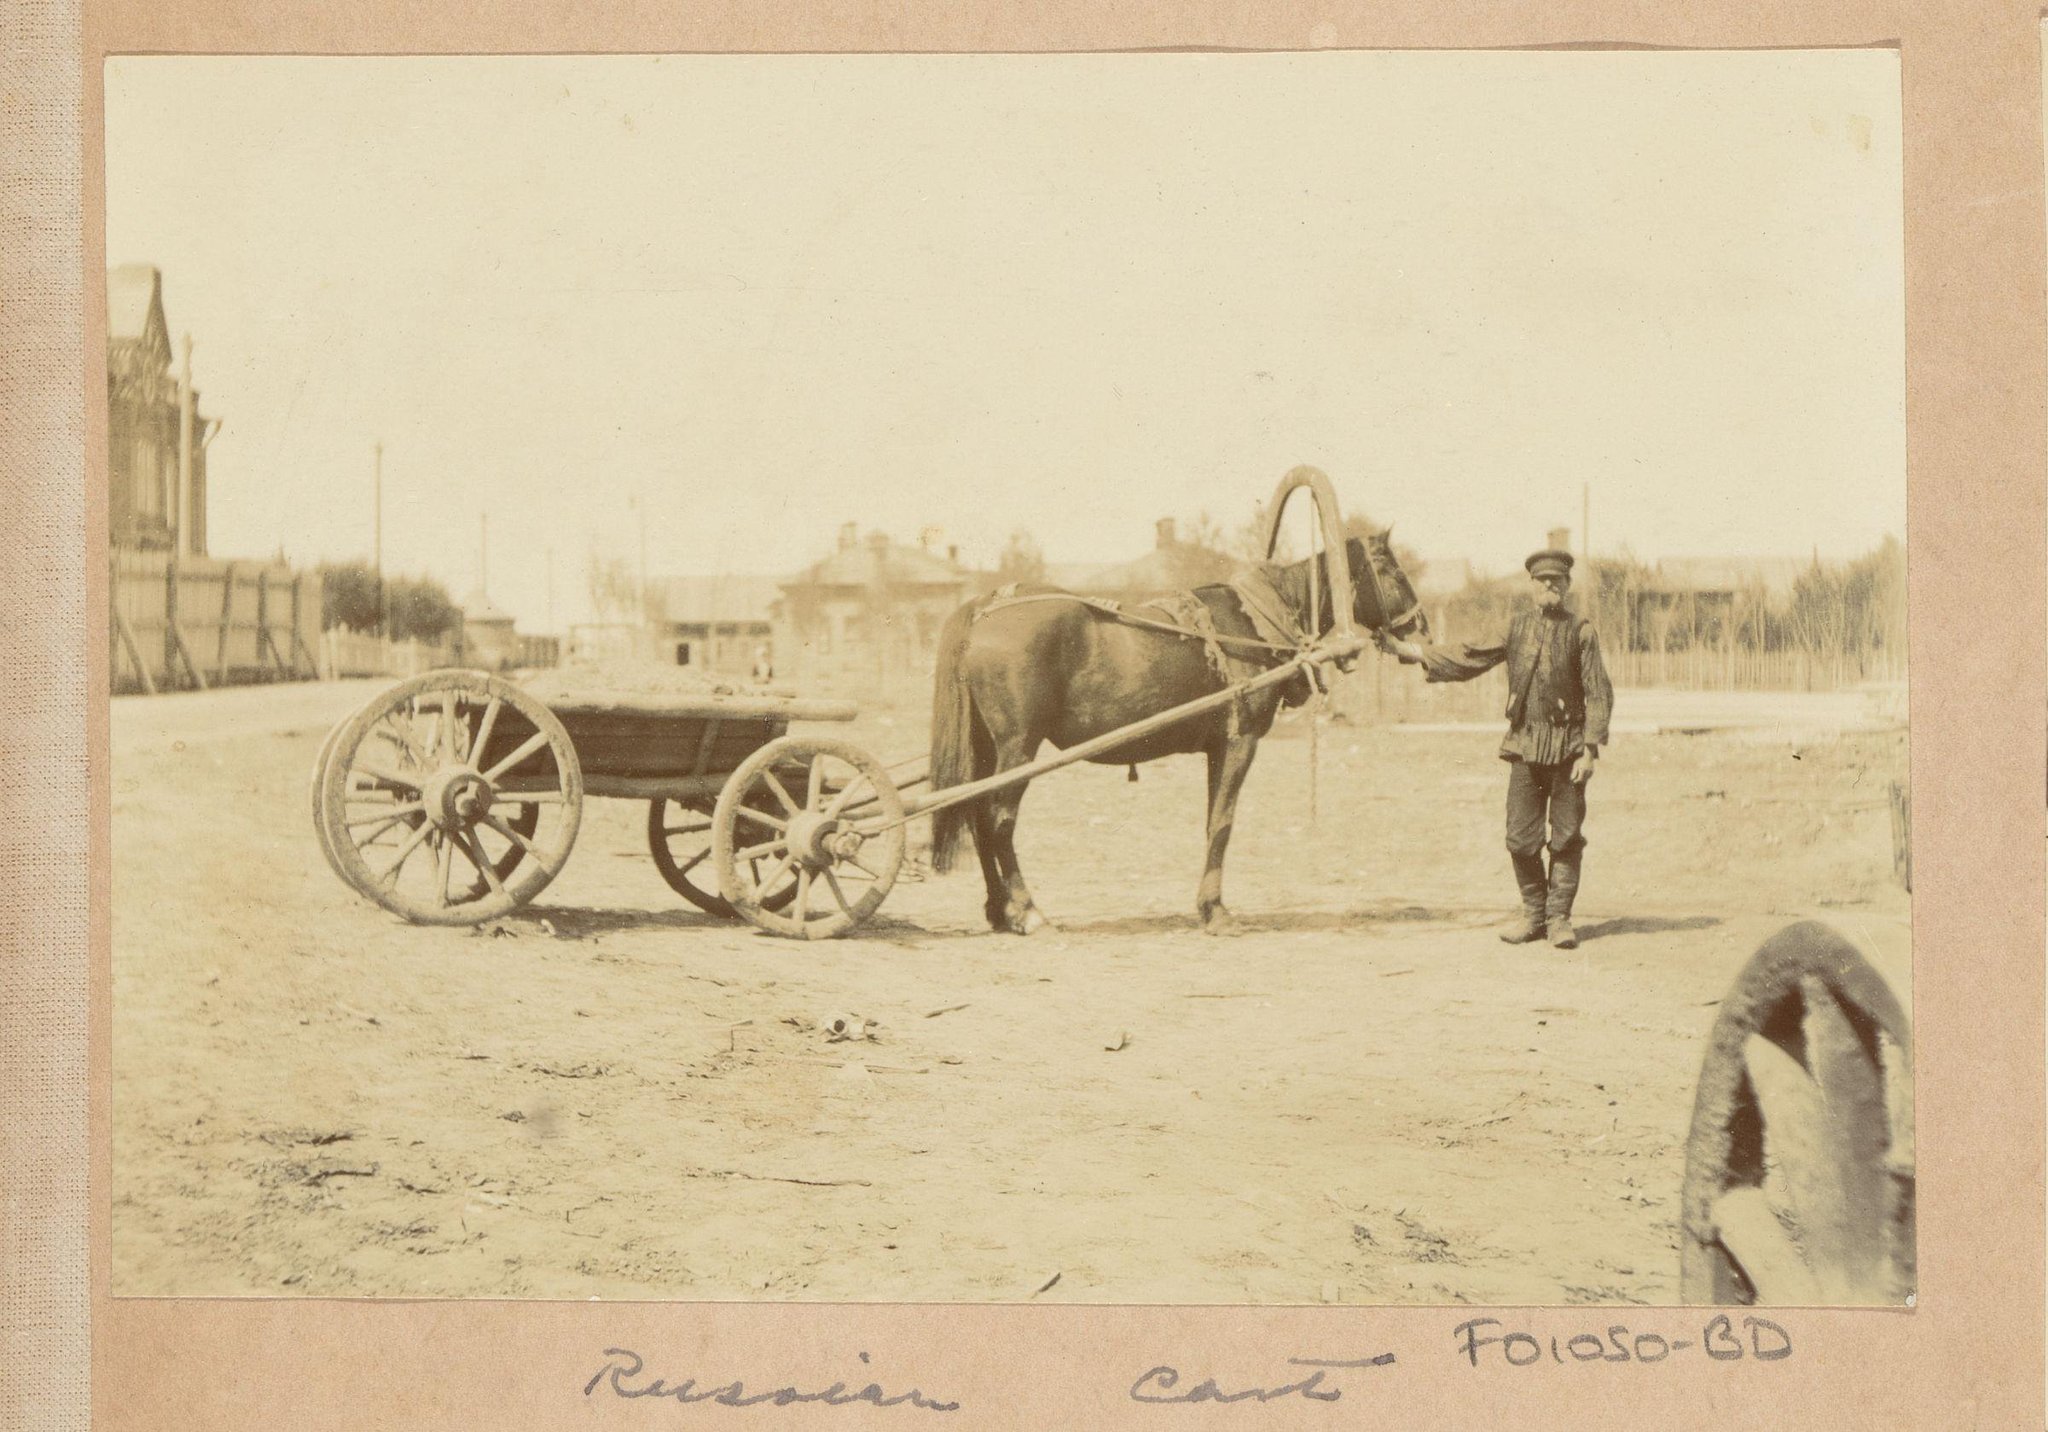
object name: photograph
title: Man met paard en wagen in Rusland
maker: joseph cheetham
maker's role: engineer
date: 1903-1904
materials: photographic support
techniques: gelatin silver print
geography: russia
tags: four-wheeled, animal-drawn vehicle, e.g.: cab, carriage, coach (+ conveyance for transport of persons), russia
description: Onderdeel van Fotoalbum van de Engelse familie Cheetham met opnames van hun verblijf in Rusland.